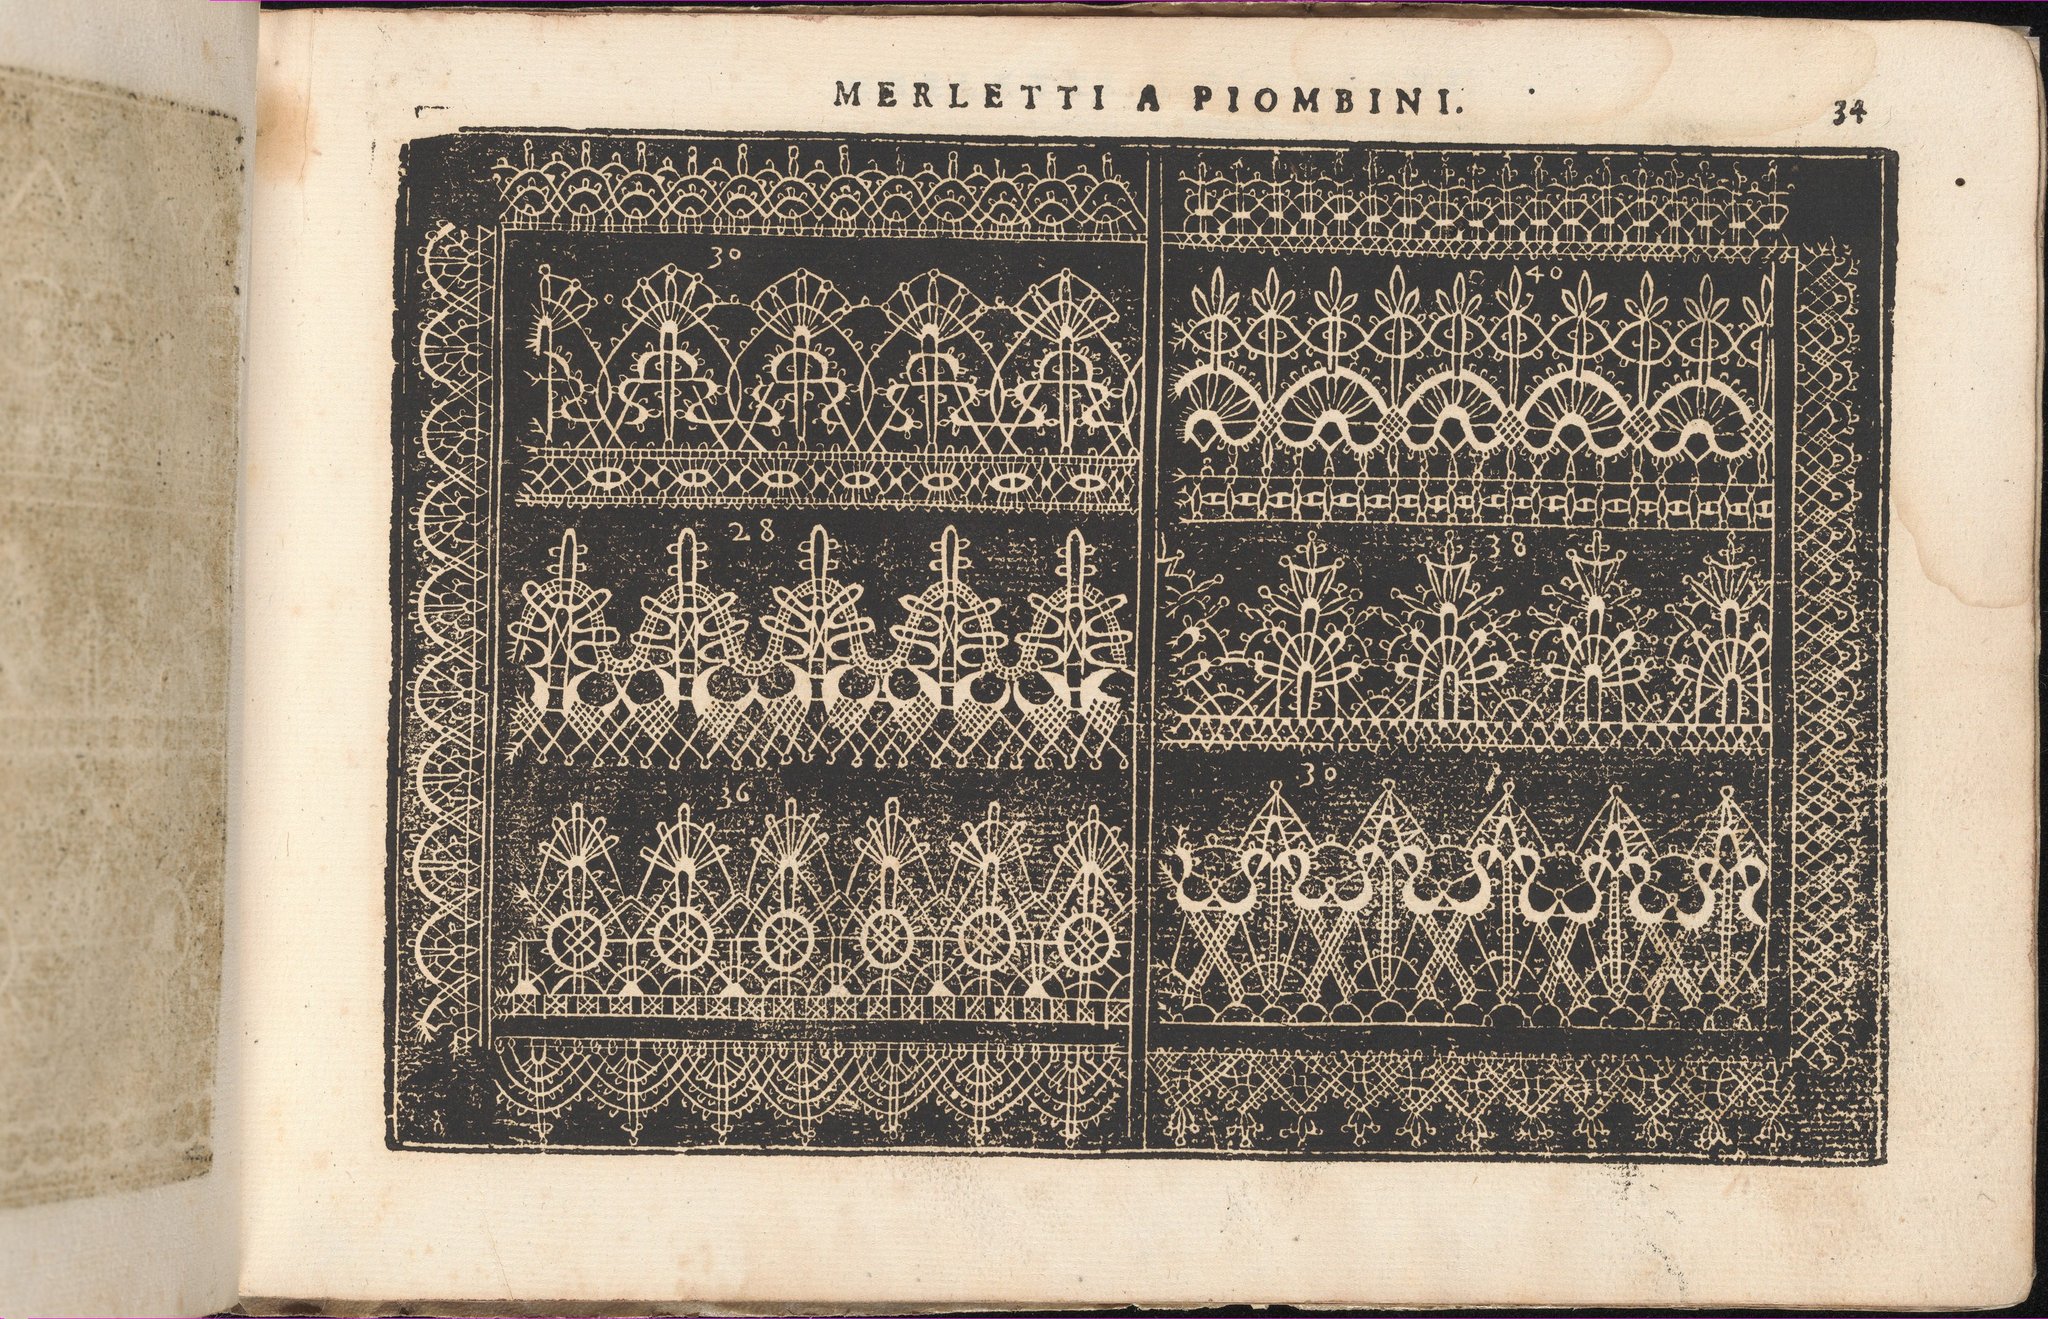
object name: book print ornament architecture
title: Teatro delle Nobili et Virtuose Donne..., page 30 (recto)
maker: isabella catanea parasole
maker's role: author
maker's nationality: italian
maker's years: 1565-1625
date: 1616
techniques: engraving, woodcut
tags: ornament